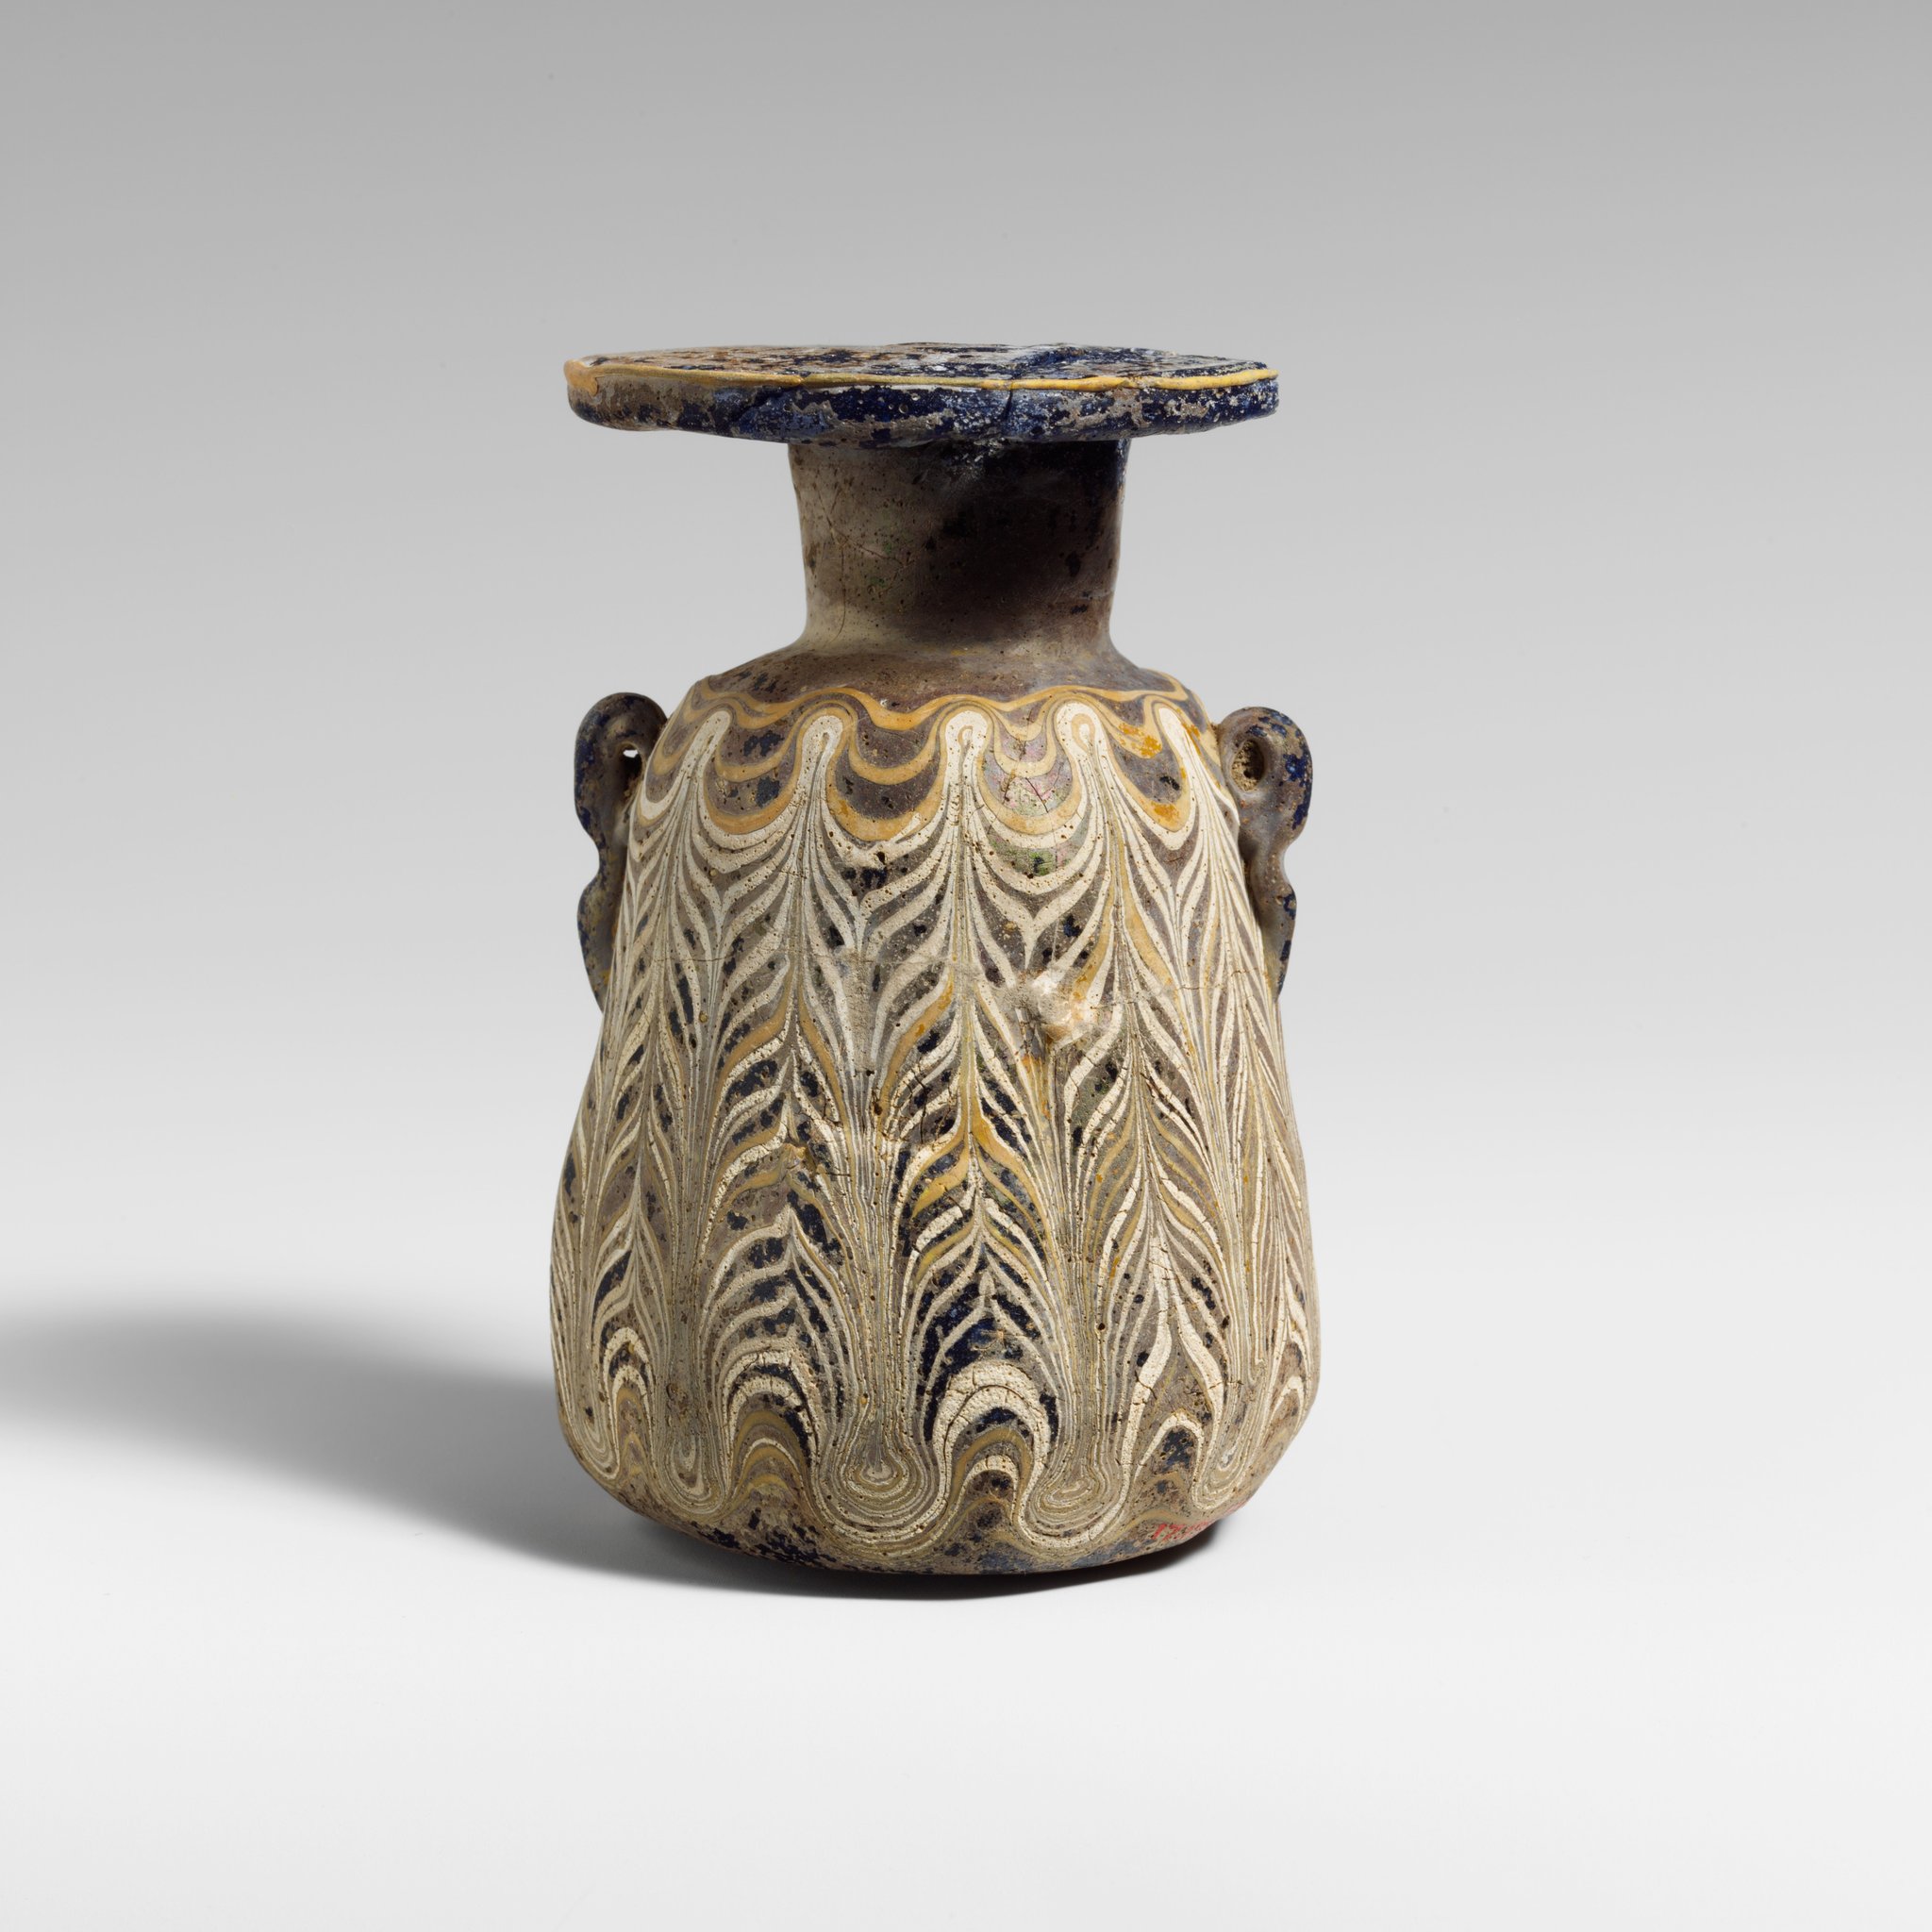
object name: alabastron, squat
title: Glass squat alabastron (perfume bottle)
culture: greek or eastern mediterranean or italian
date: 334-268 BCE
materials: glass